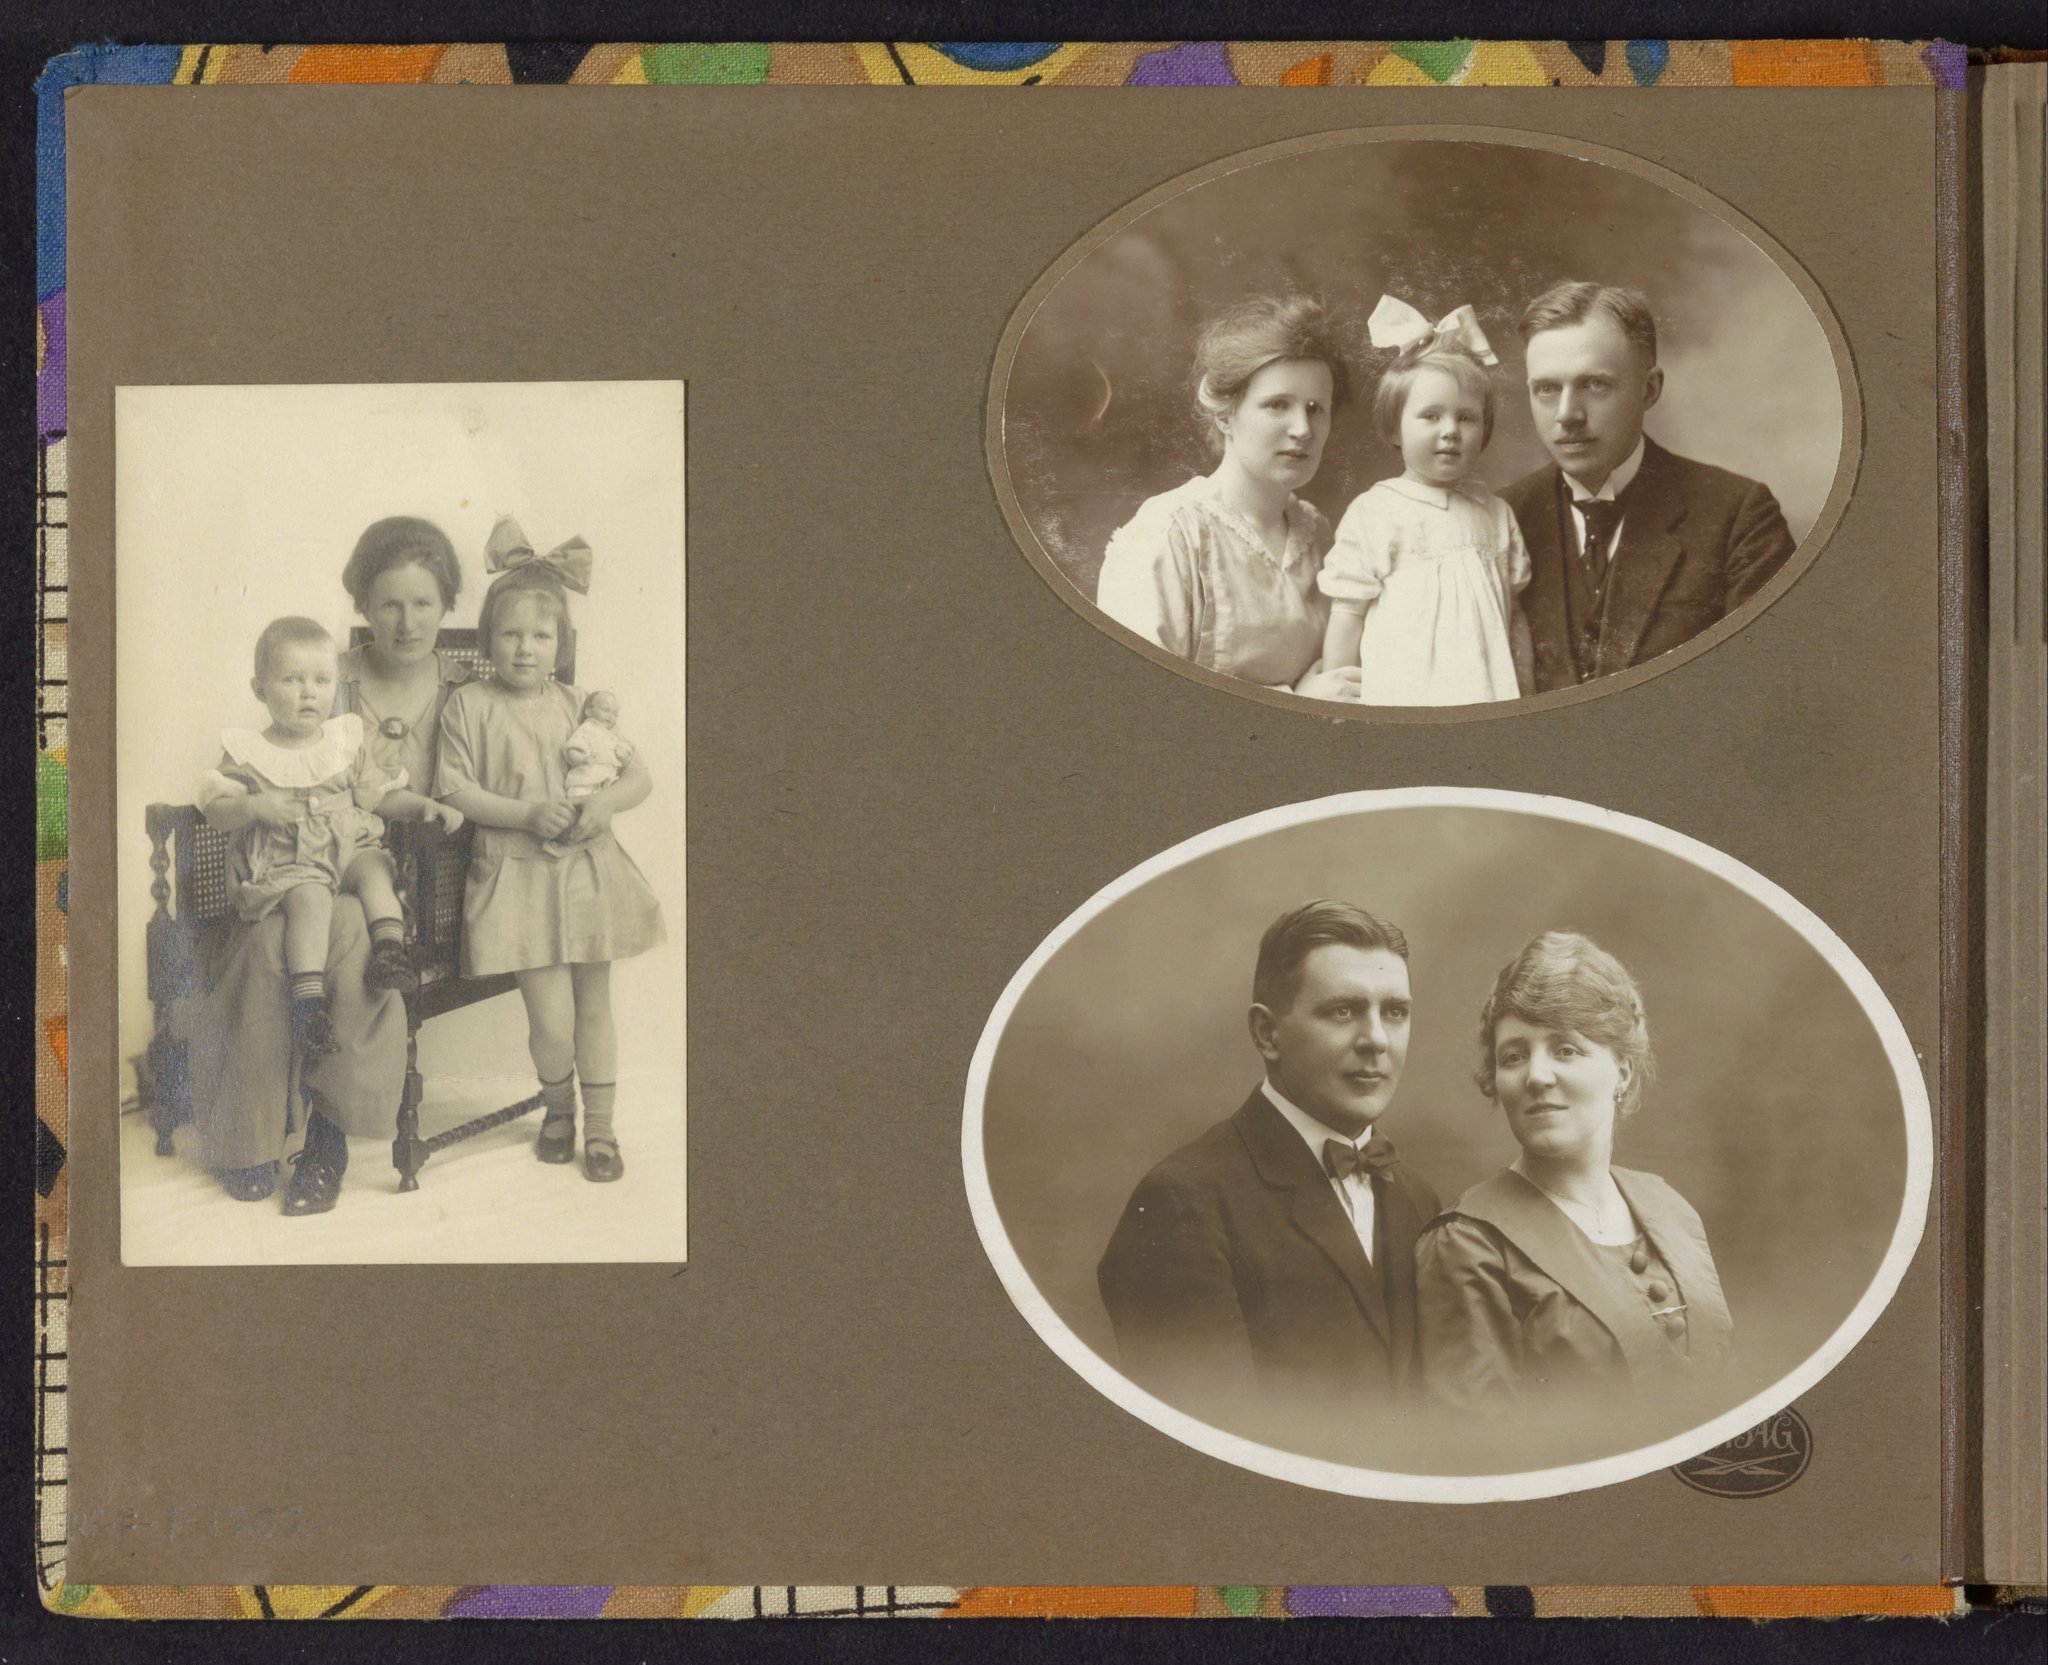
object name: album leaf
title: Familiefoto's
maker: Anonymous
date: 1900-1925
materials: cardboard, photographic support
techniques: gelatin silver print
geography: netherlands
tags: family group, especially parents with their child(ren), marriage, married couple, 'matrimonium', mother and baby or young child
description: Albumblad met drie familiefoto's van volwassenen en kinderen. Onderdeel van Fotoalbum van een onbekende Nederlandse familie met connecties in Suriname en Nederlands-Indië (1).